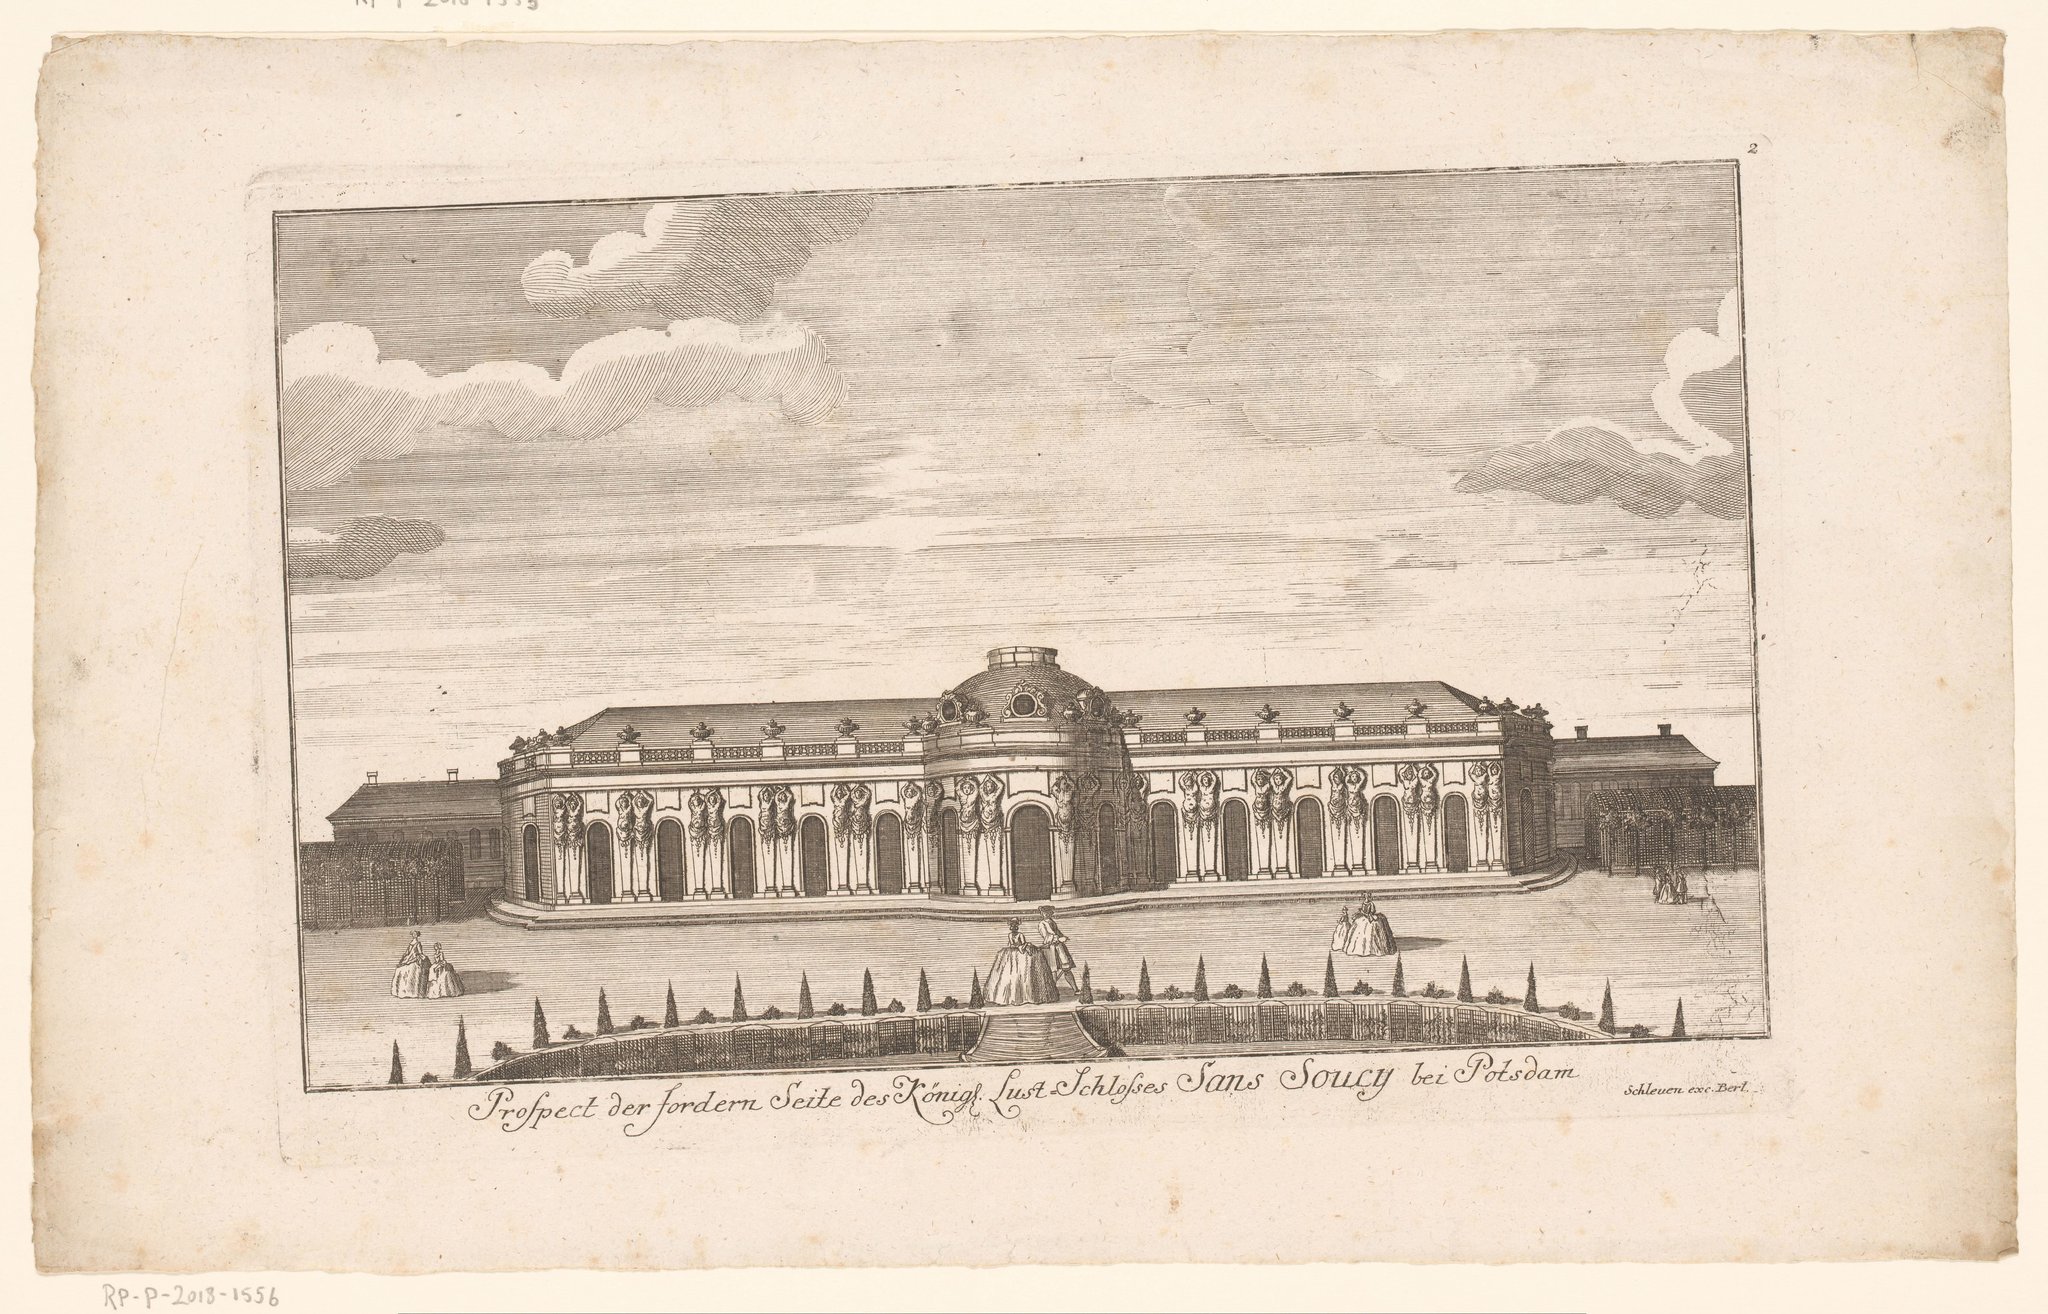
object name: print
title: Prospect der fordern seite des Königl. Lust-Schlosses Sans Soucy bei Potsdam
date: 1747-1774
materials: paper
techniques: engraving, etching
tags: castle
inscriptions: collector's mark: Lugt 2228